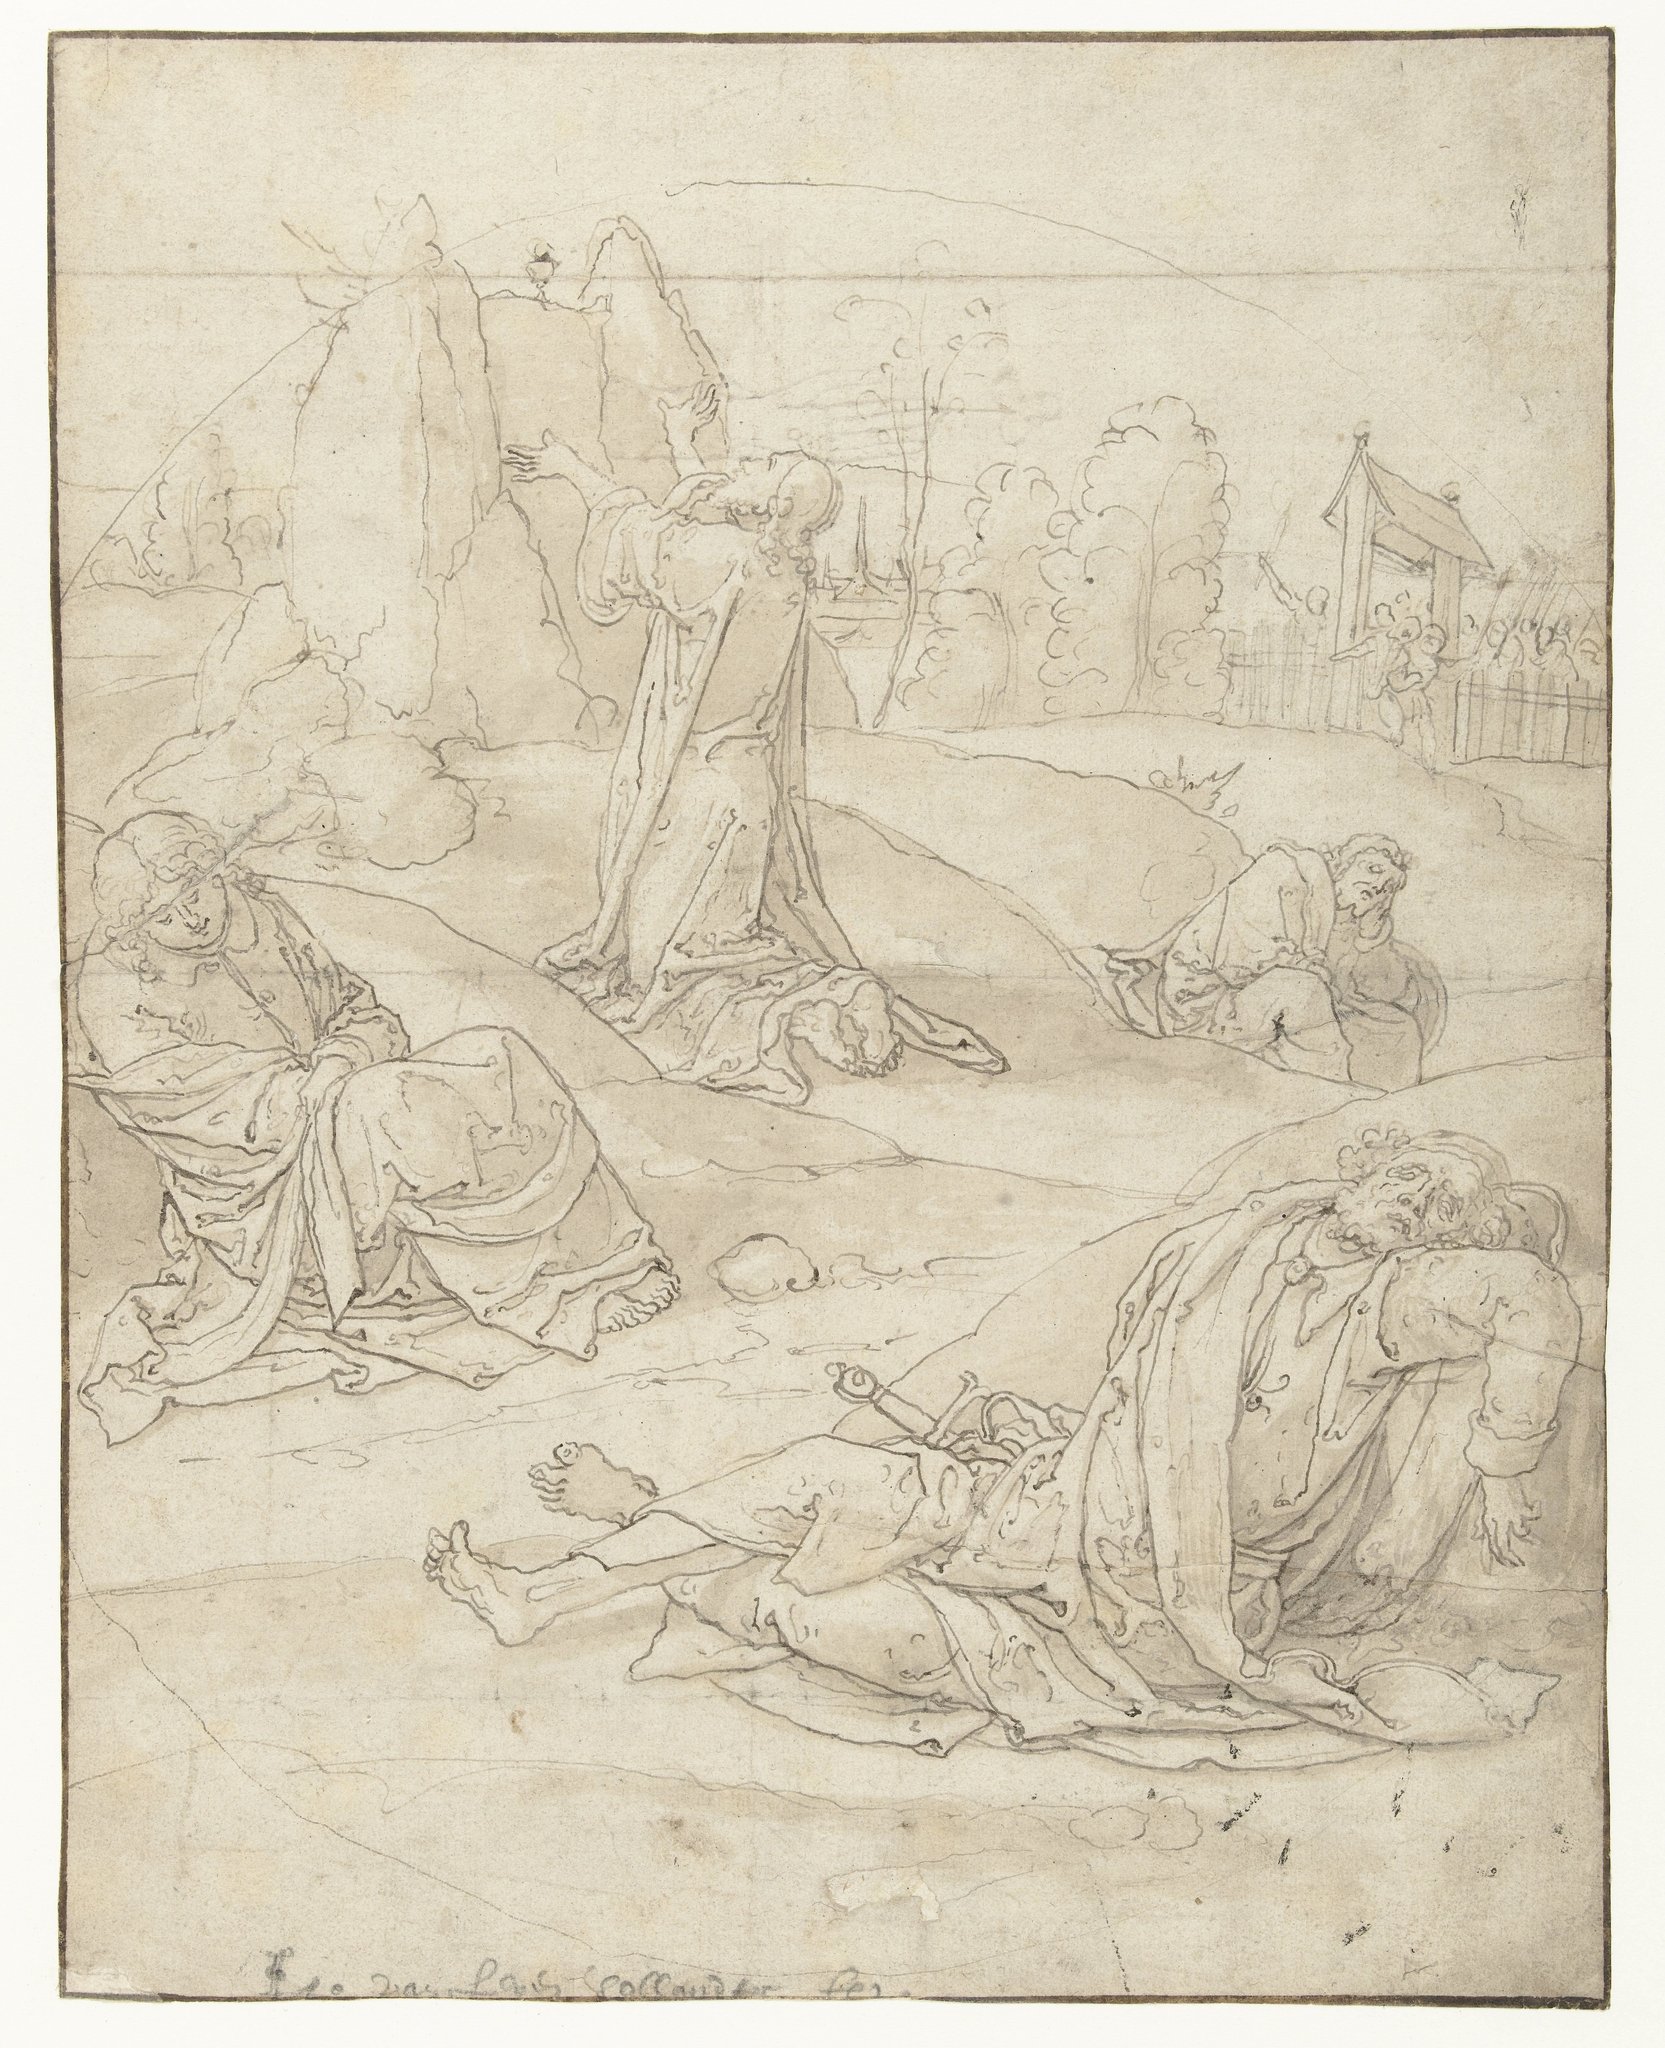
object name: drawing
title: Christus in Gethsemane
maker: pieter coecke van aelst (i)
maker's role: draughtsman, print maker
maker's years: 1502-1550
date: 1515-1550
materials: chalk, ink, paper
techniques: pen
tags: gethsemane, mount of olives, 'oelberg' (matthew 26:36-56; mark 14:32-52; luke 22:39-53; john 18:1-12)